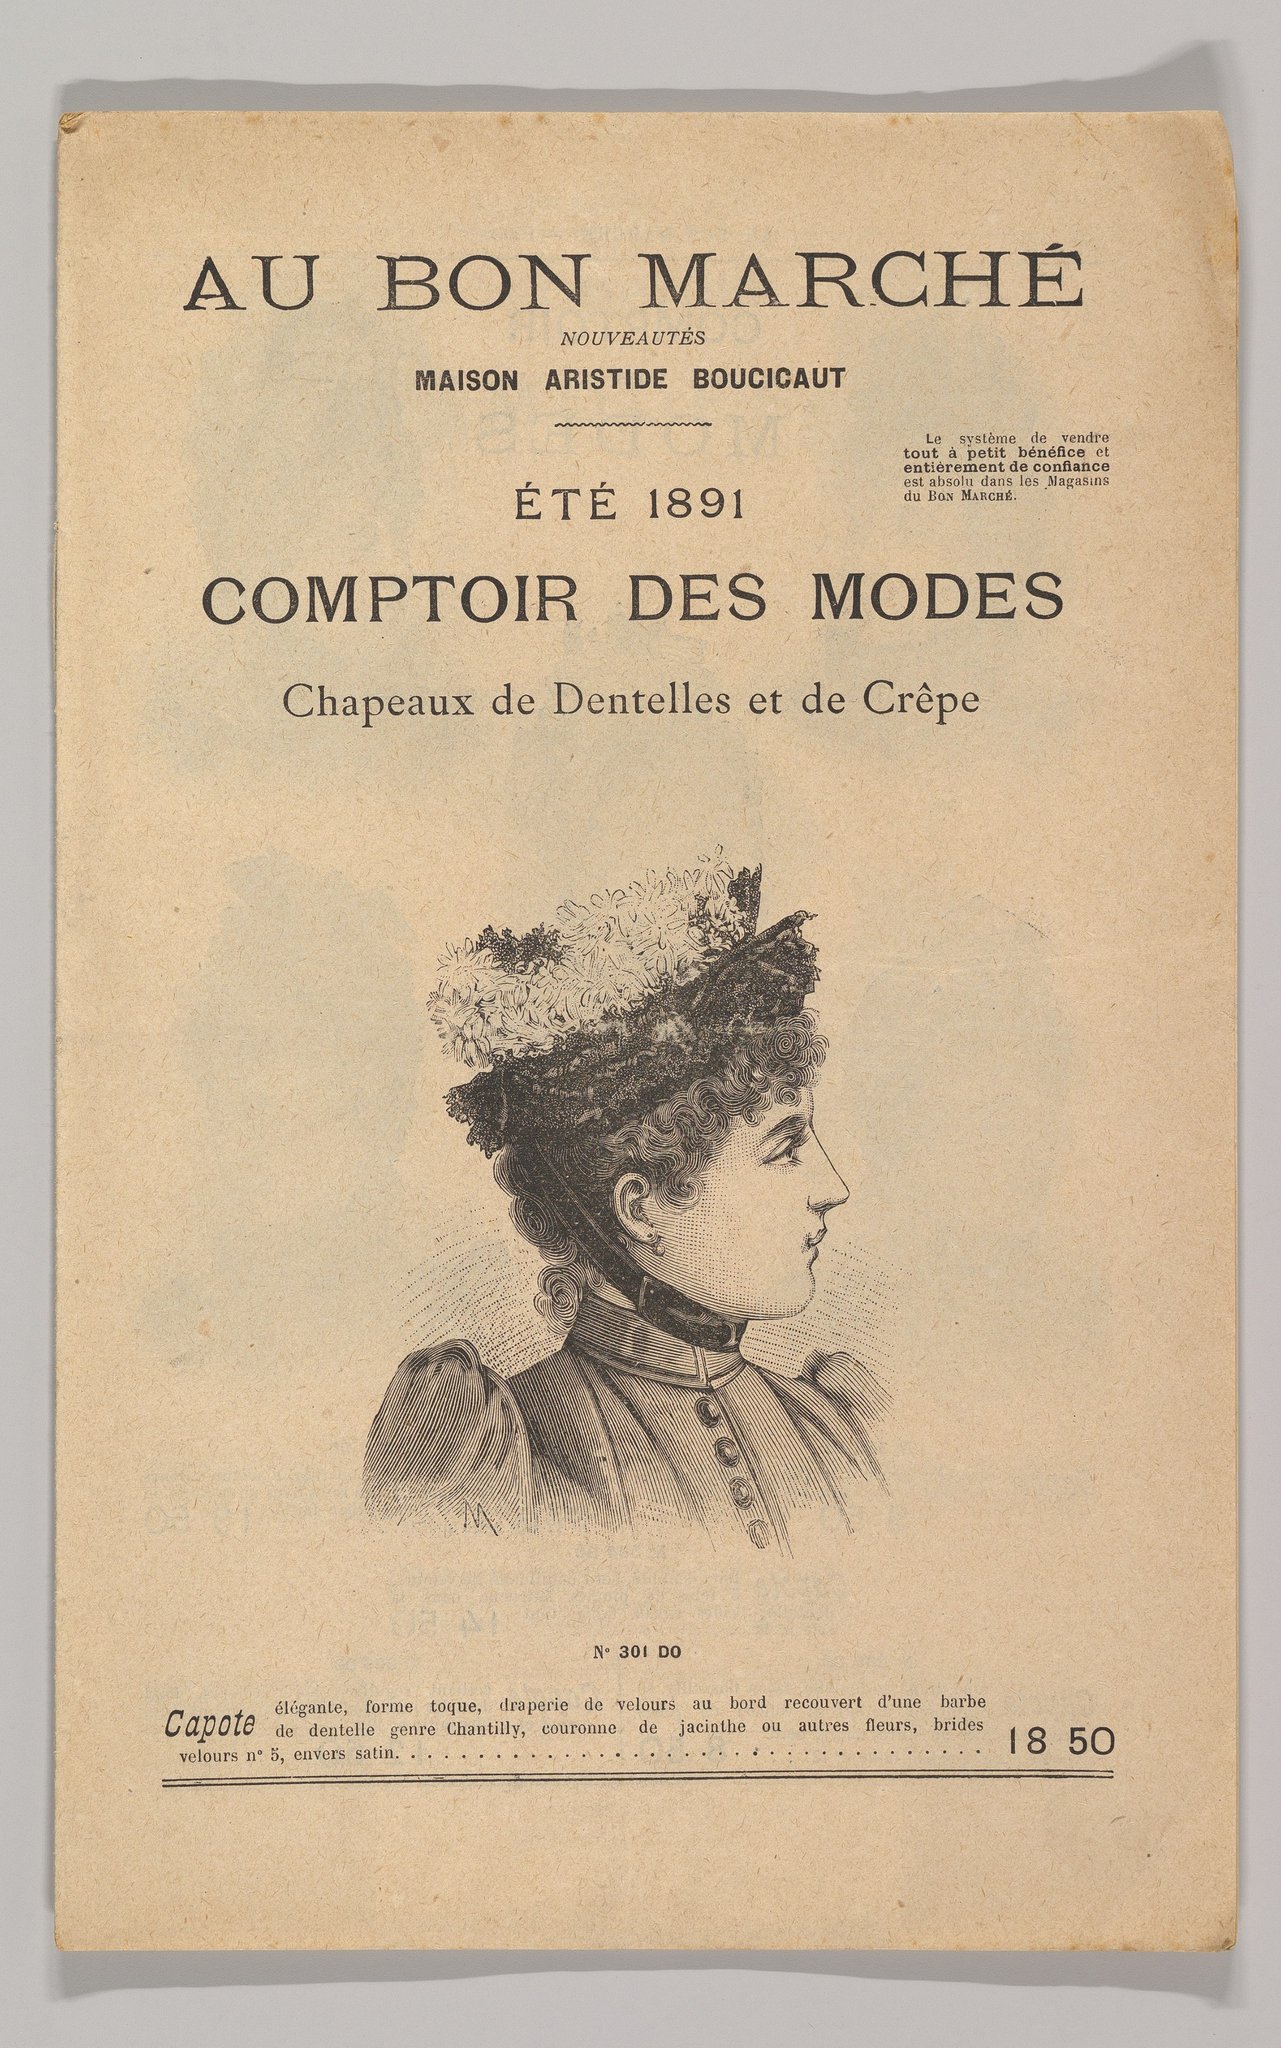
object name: book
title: Au Bon Marché-Comptoir des Modes, Chapeaux de Dentelles et de Crêpe, Été 1891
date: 1891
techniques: engraving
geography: france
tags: profiles,women